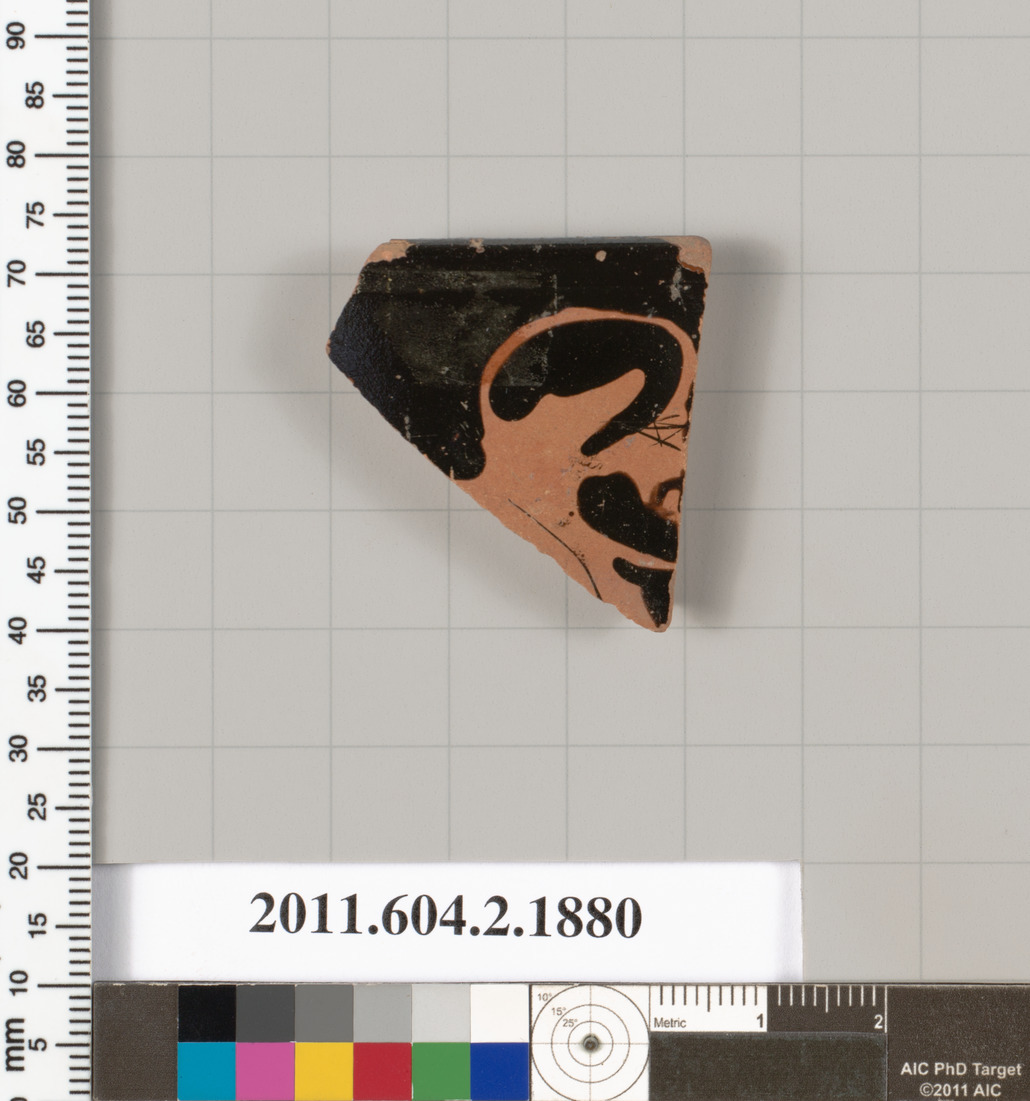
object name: skyphos fragment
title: Terracotta rim fragment of a skyphos (deep drinking cup)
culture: greek, attic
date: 425-401 BCE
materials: terracotta